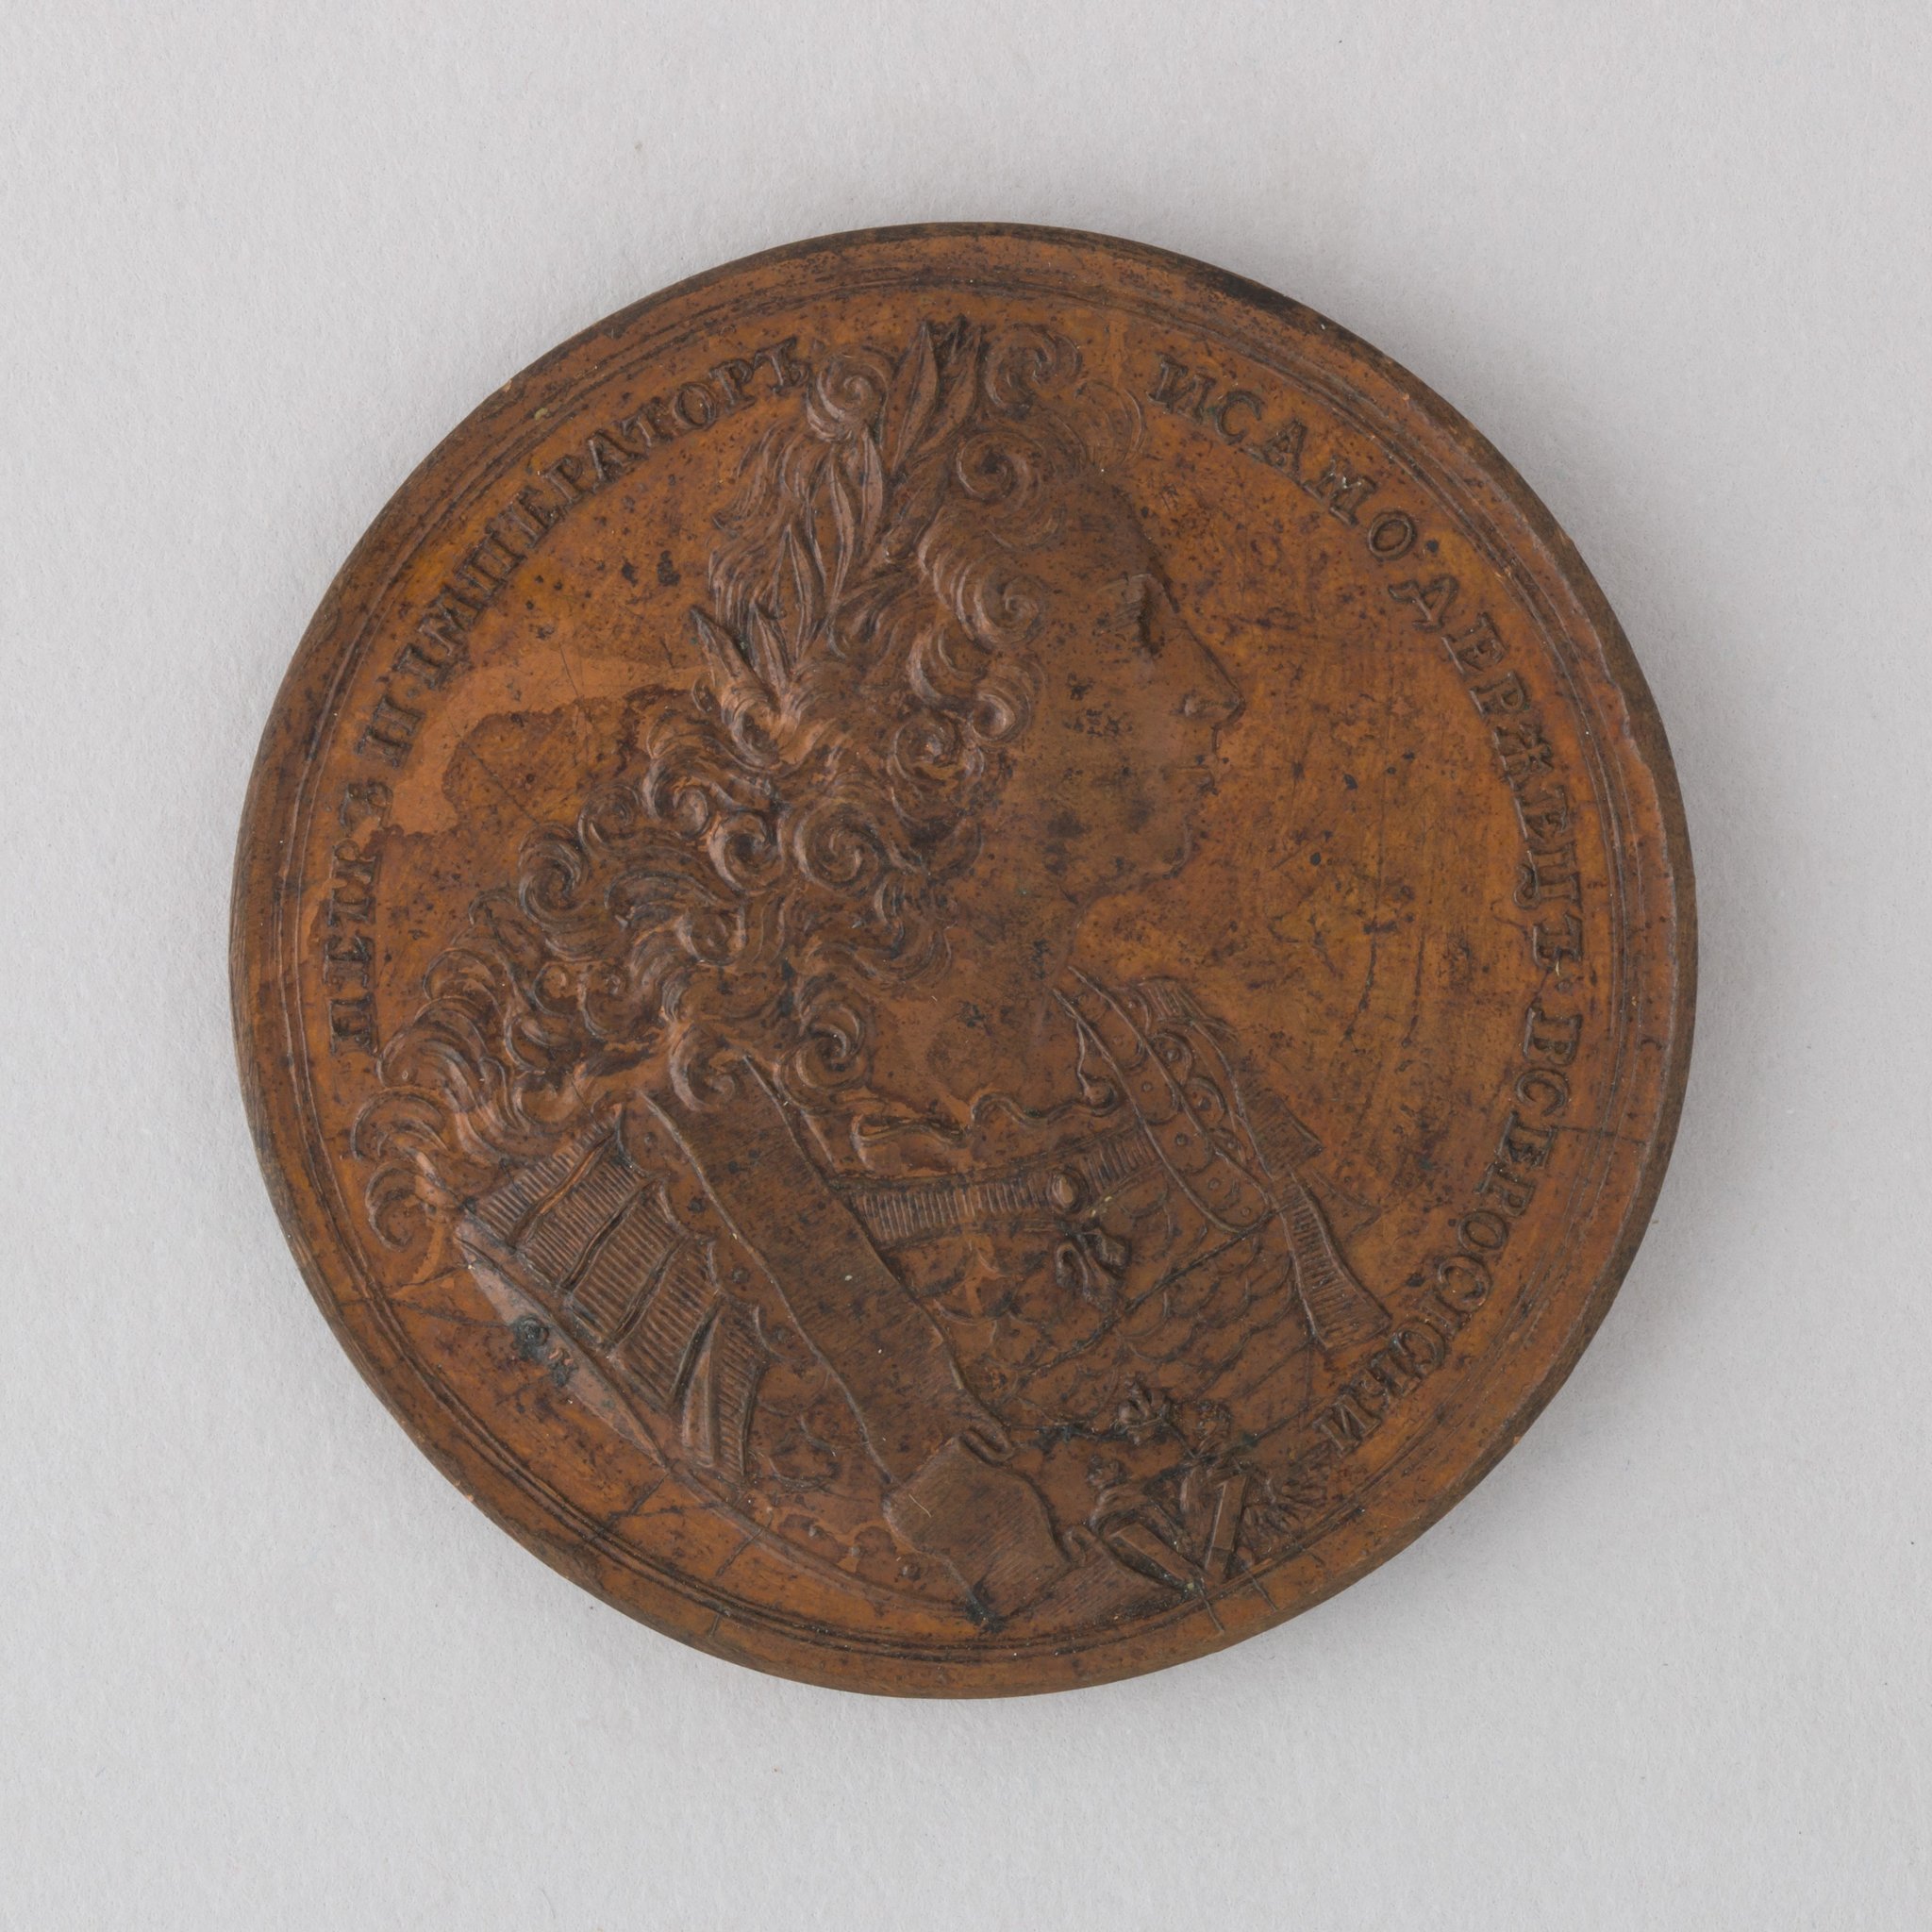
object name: medal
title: Medal Commemorating the Coronation of Peter II at Moscow, 1728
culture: russian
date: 1728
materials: bronze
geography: russia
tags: men,profiles